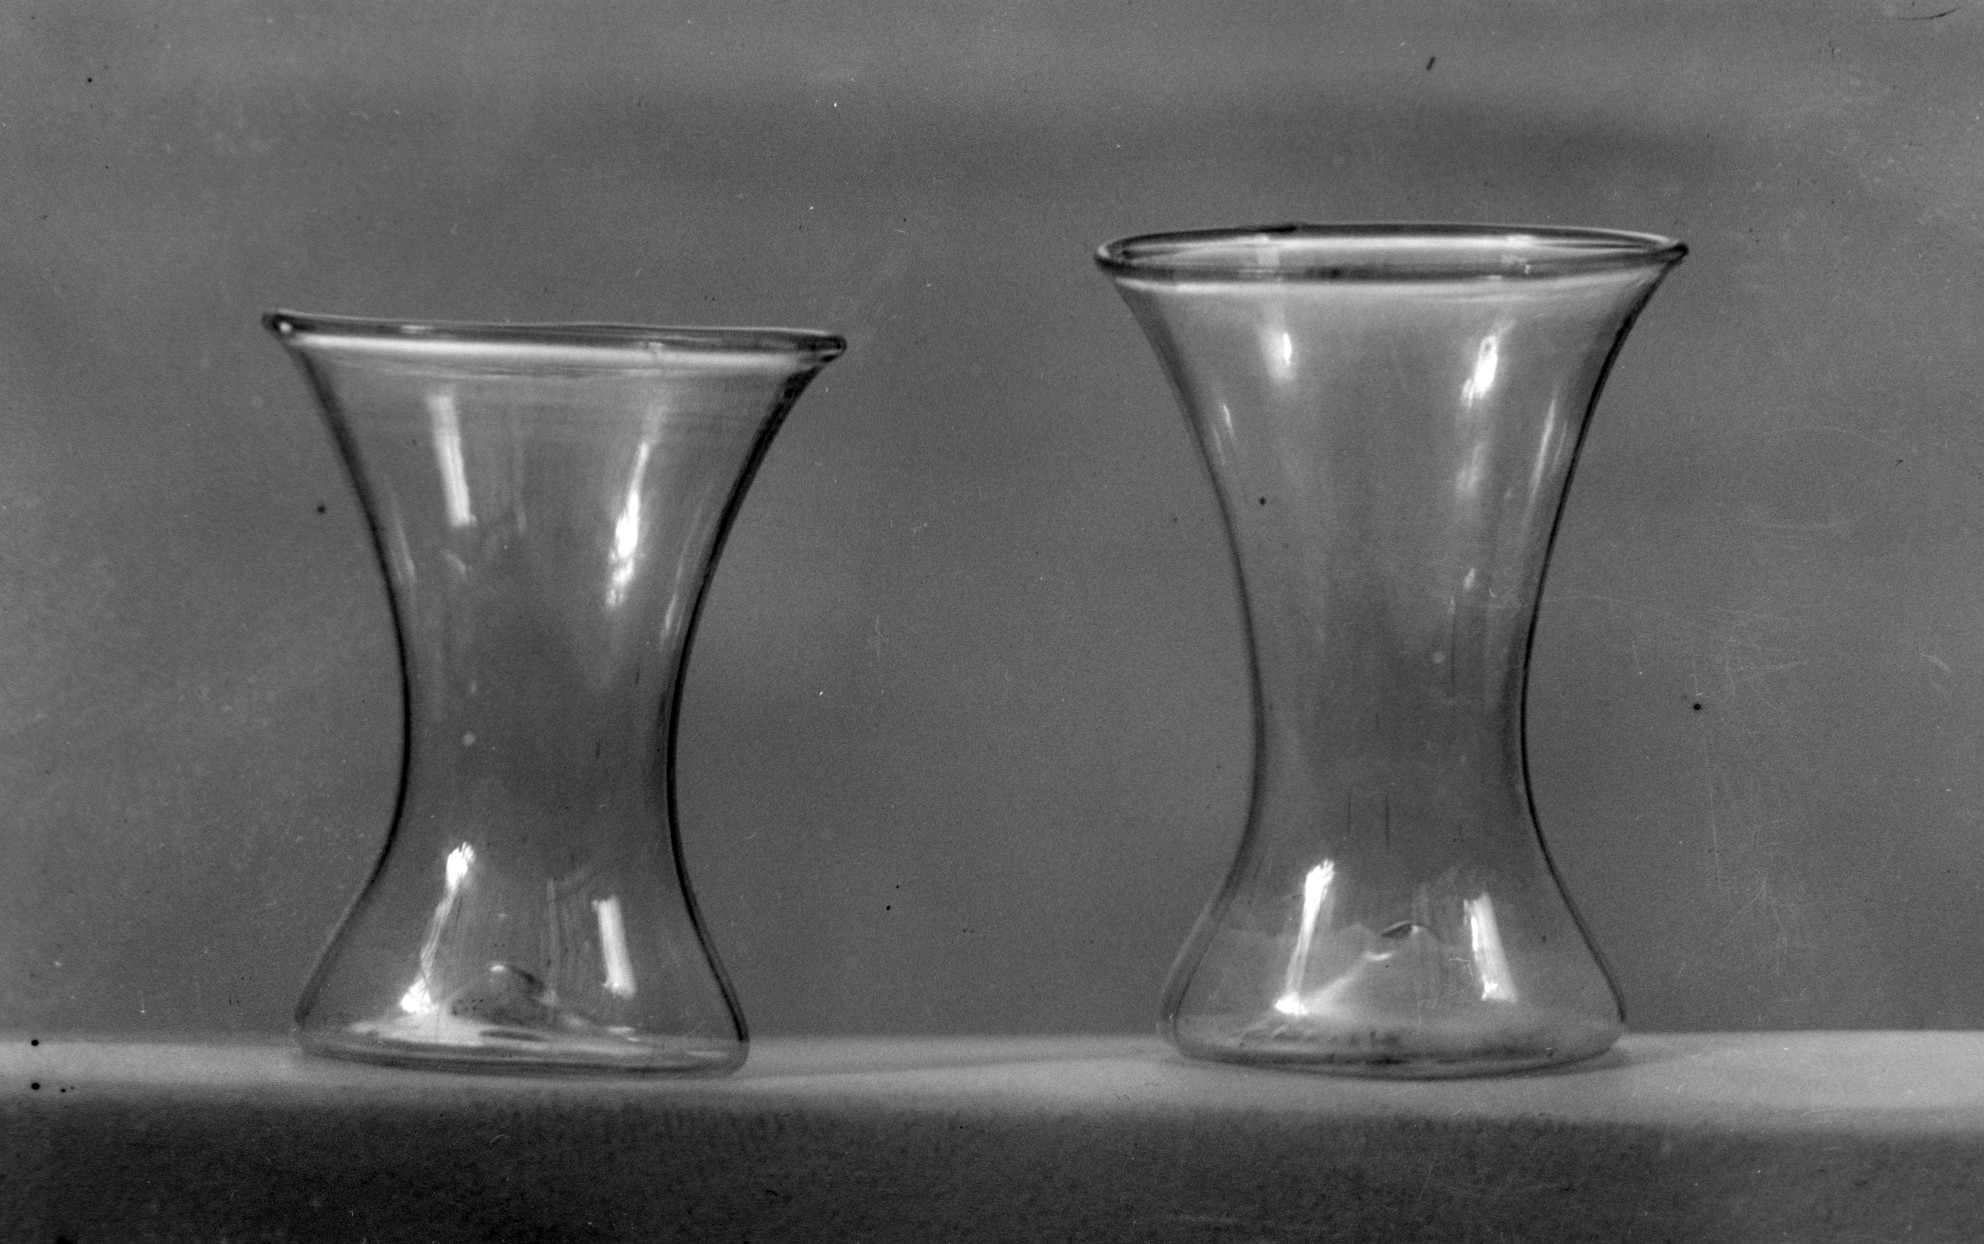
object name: beaker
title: Miniature beaker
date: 1801-1833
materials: glass